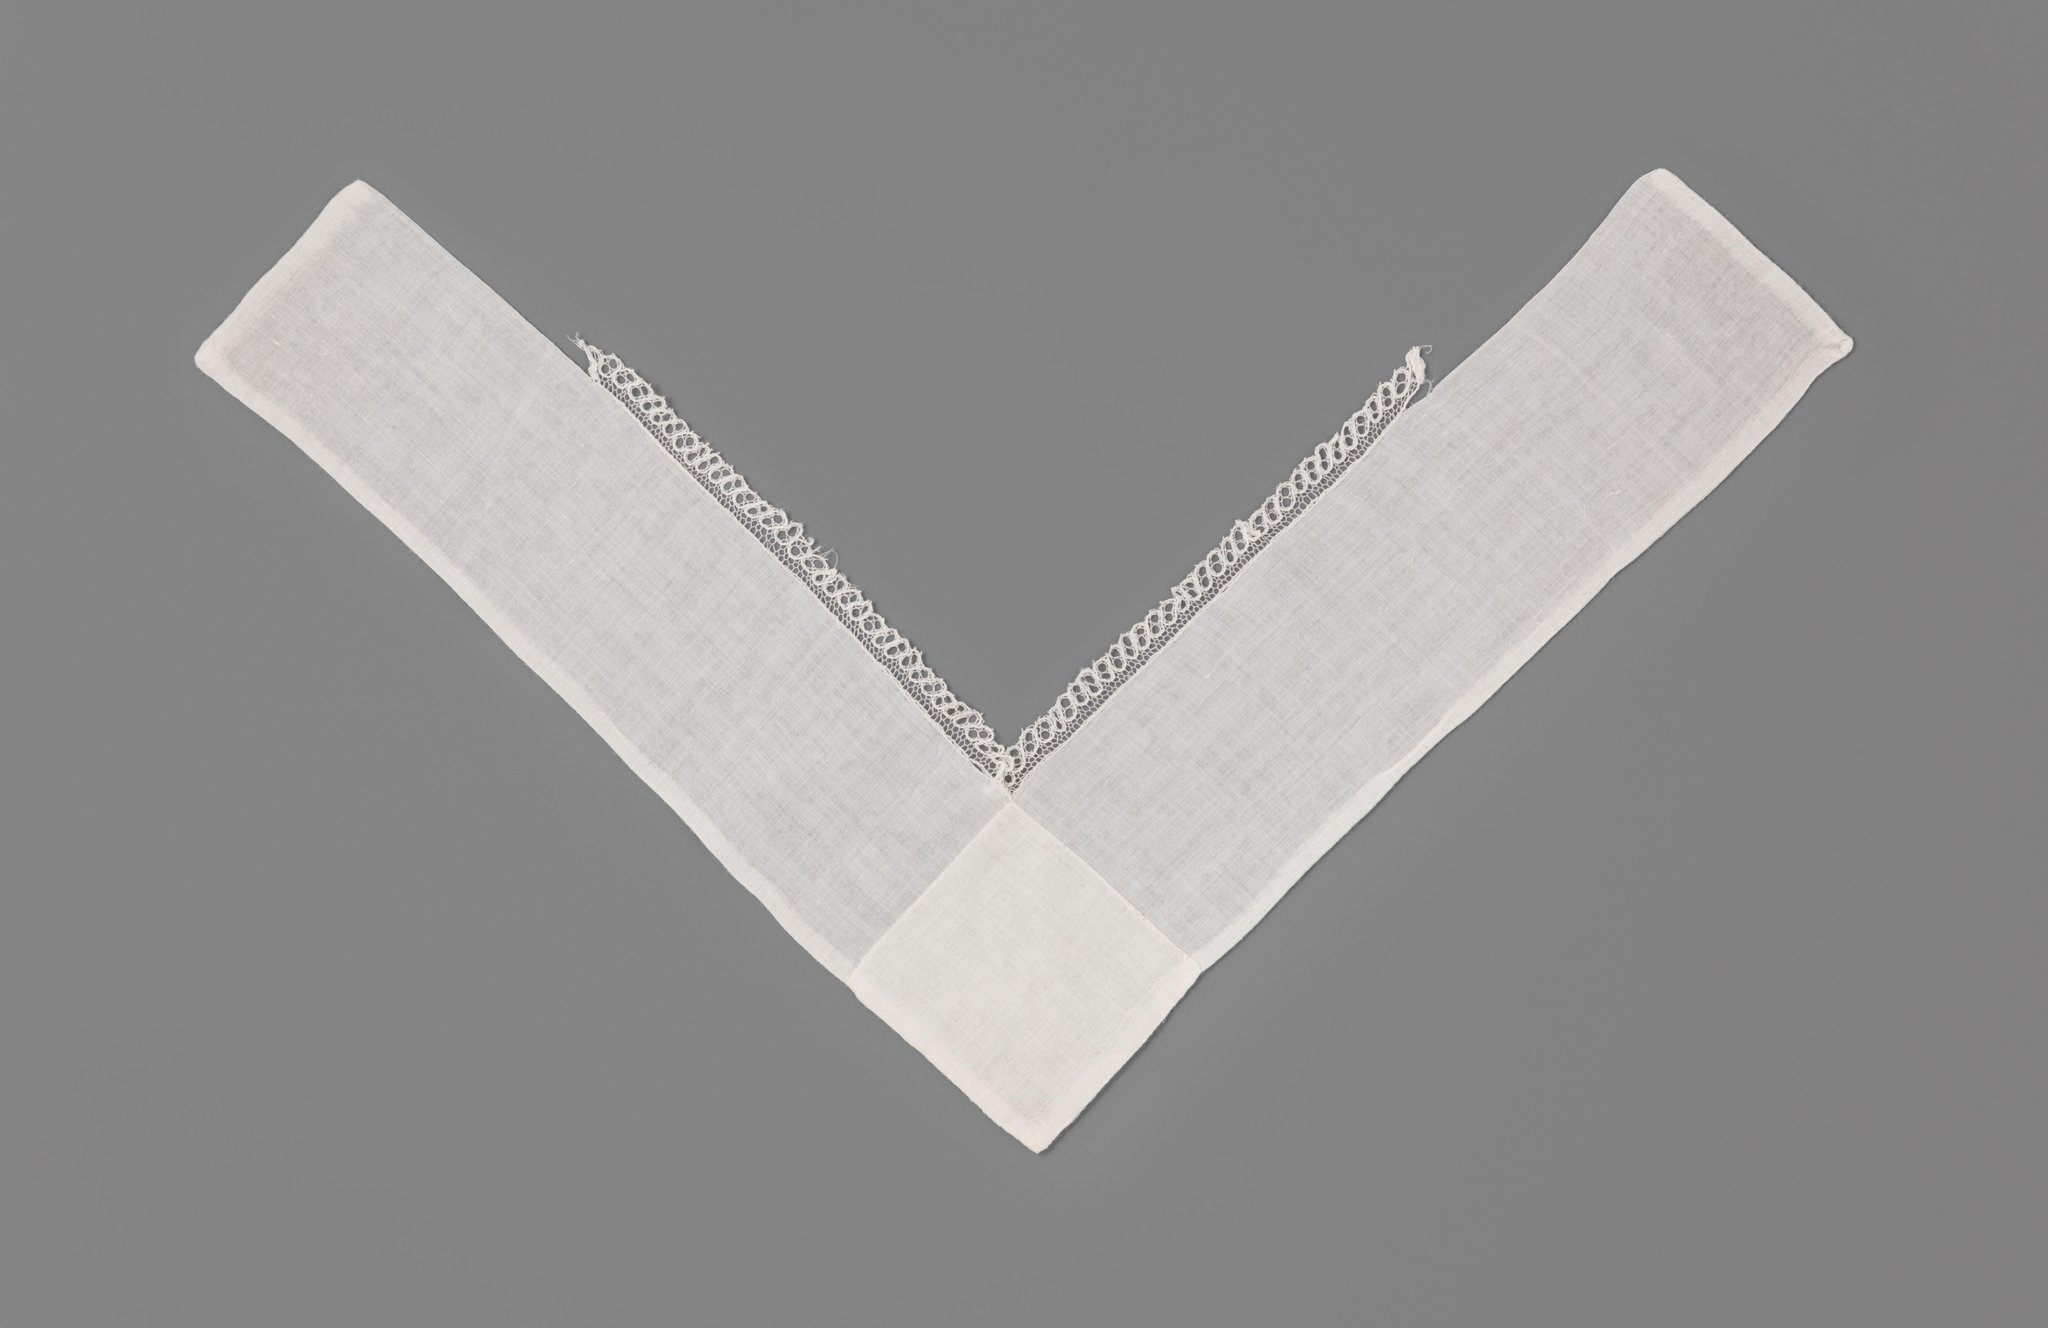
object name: womenswear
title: Modestie van dubbel genaaid batist, met een rand kloskant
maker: Anonymous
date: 1850-1875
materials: textile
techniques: lace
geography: amsterdam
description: Modestie van dubbel genaaid batist met kloskant. Twee dubbelgenaaide rechthoeken zijn in een rechthoek over elkaar genaaid; bovenop en in de buitenhoek zijn de stroken overhands genaaid. Aan de binnenzijde is het batist afgezet met een strook kloskant, Rijssel/Lille, met een dubbele slinger van een dikkere draad als schulprand, gevuld met schuine achtjes. De modestie is gemerkt in rood: BS/ 16.